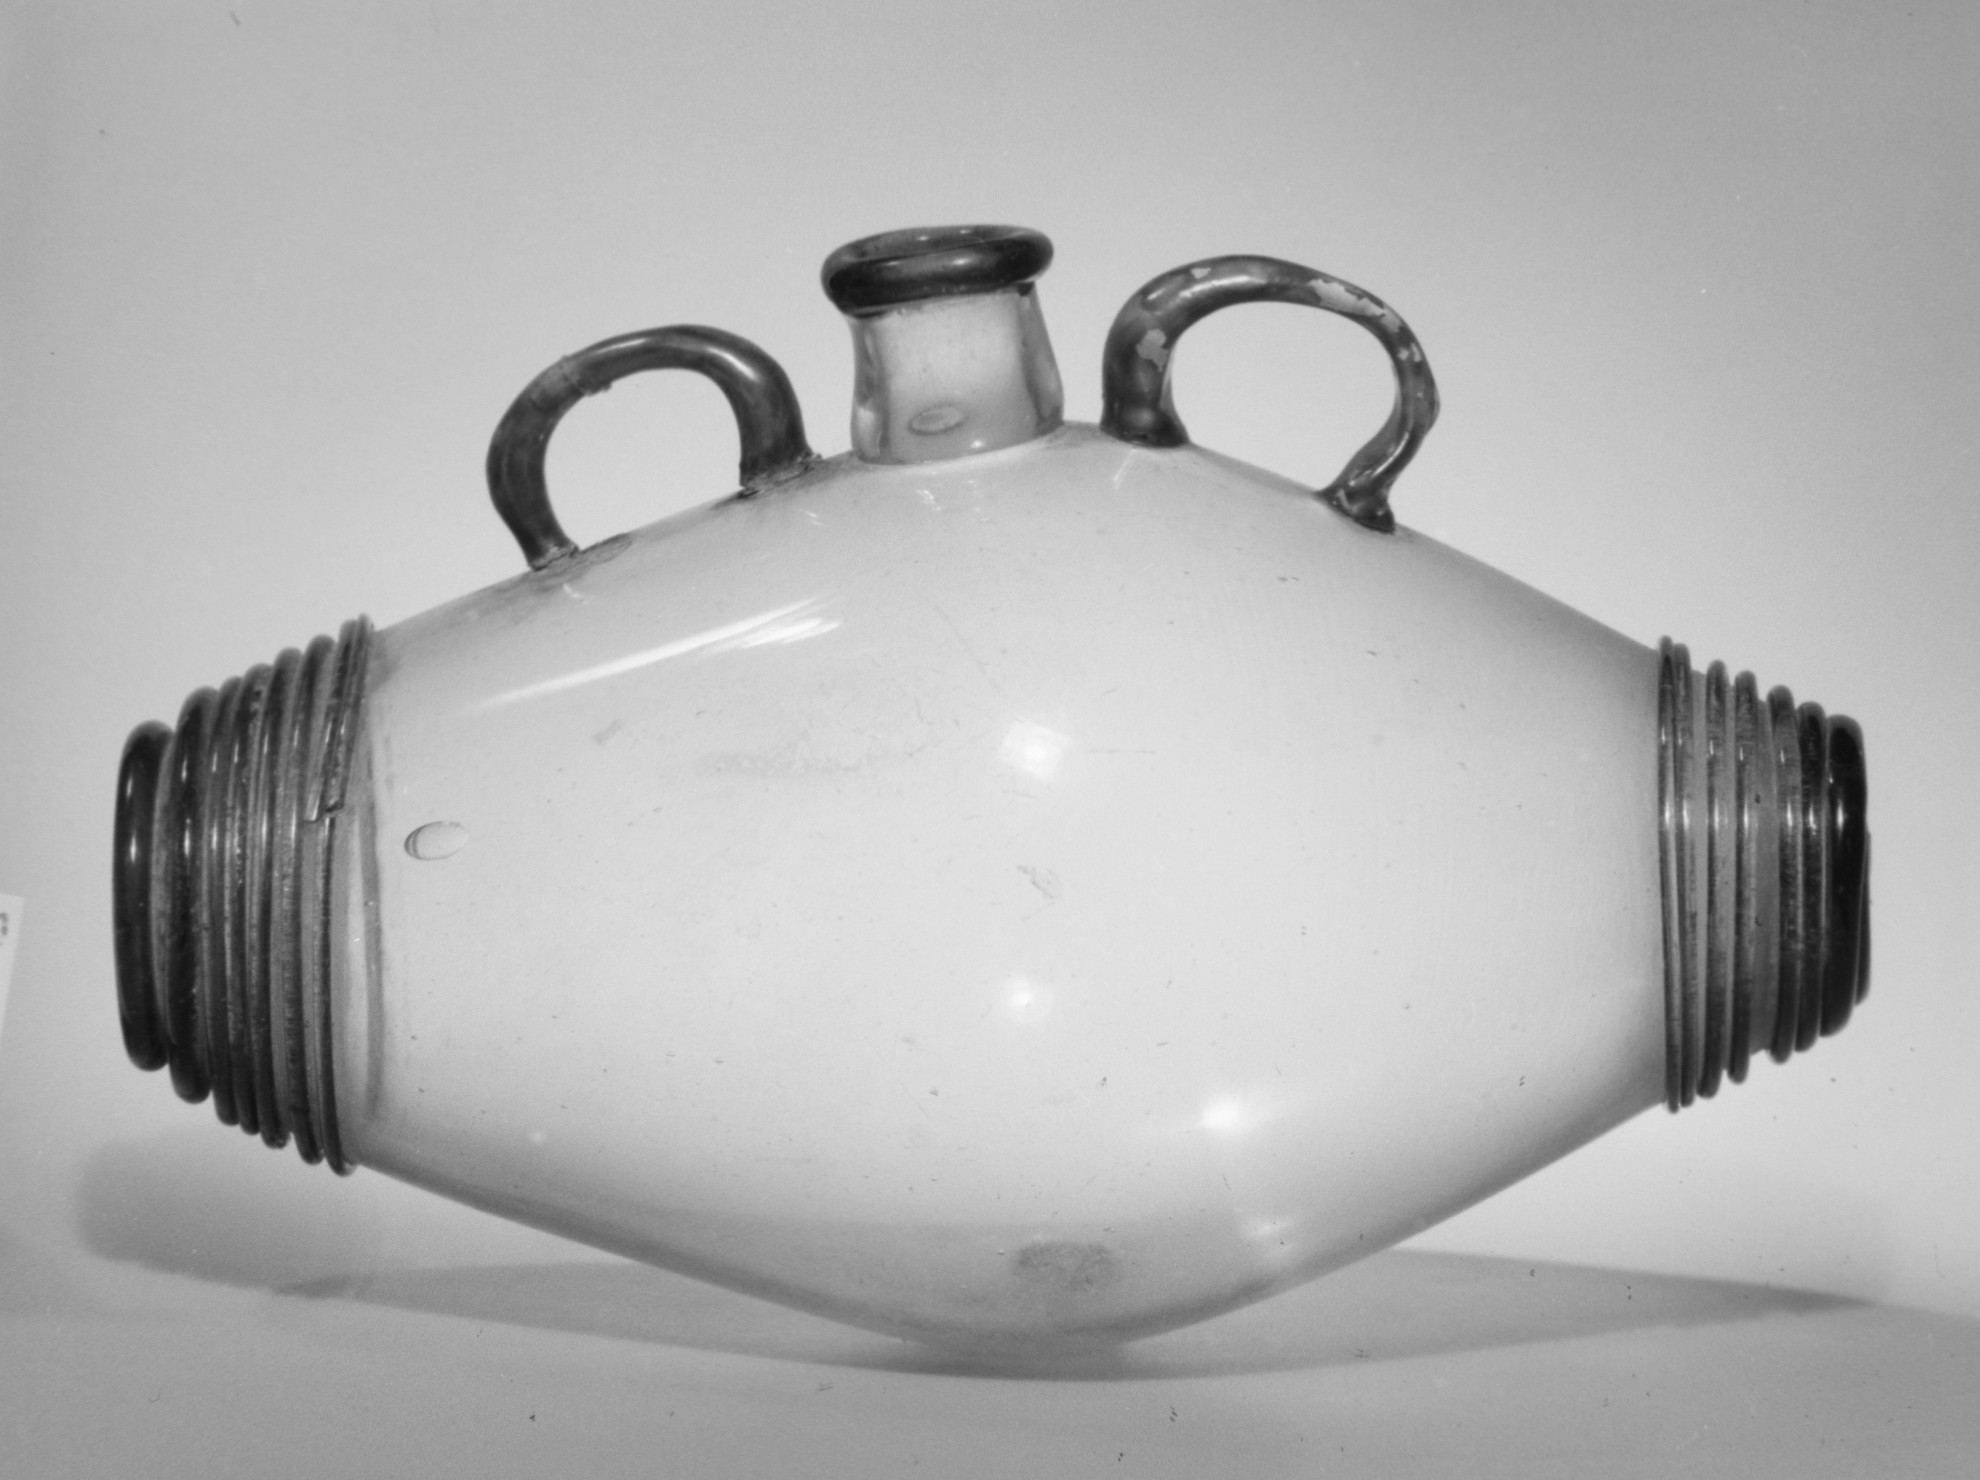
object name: flask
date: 1601-1800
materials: glass